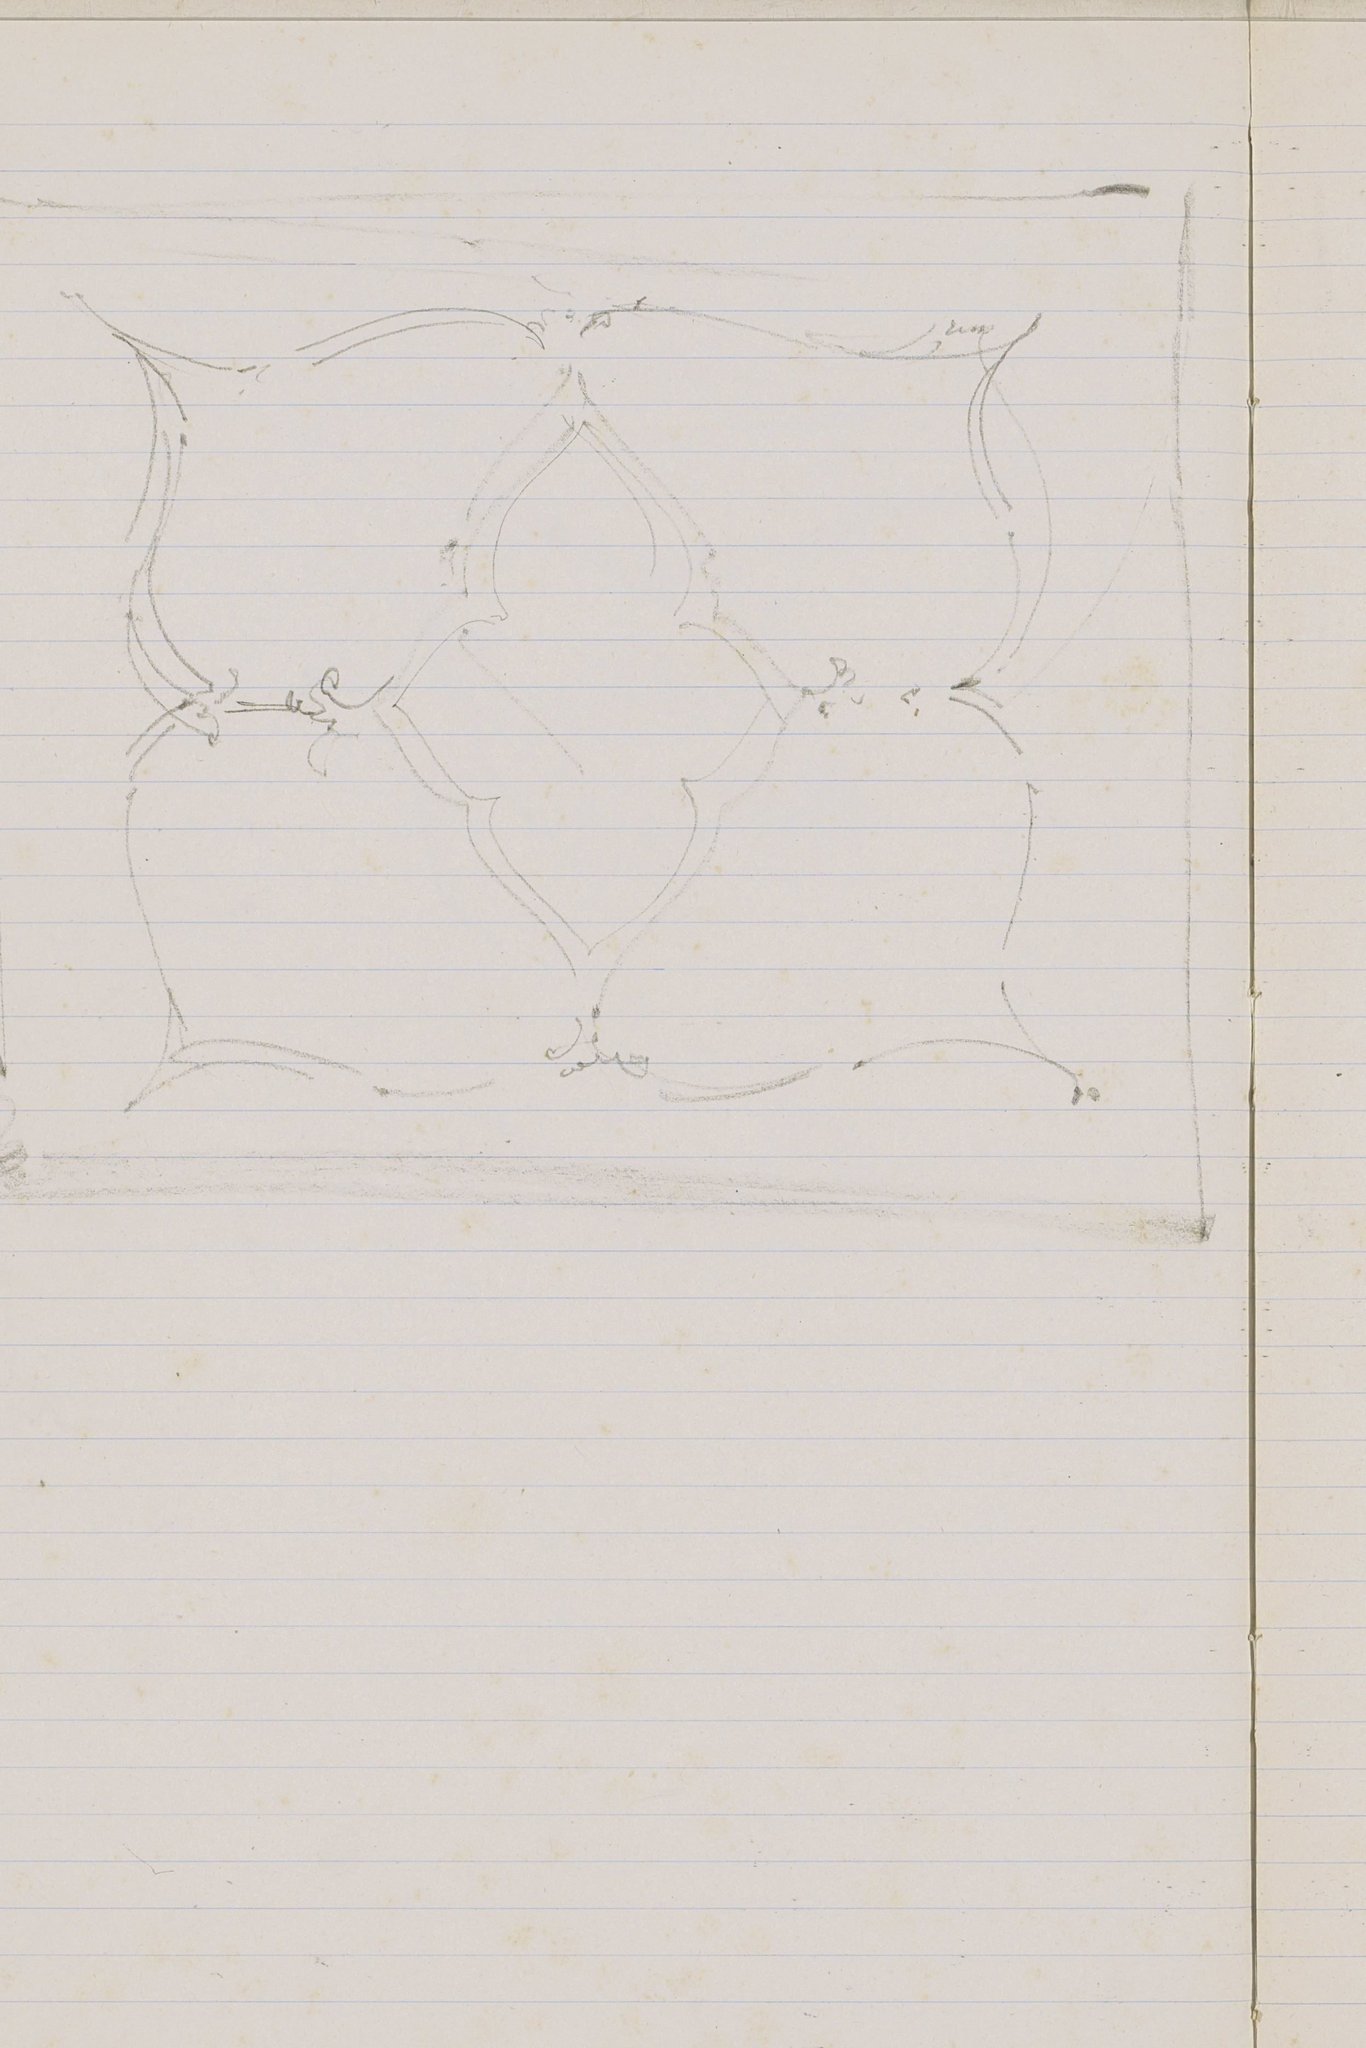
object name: sketchbook leaf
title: Gestileerde bloem in een vierkant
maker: gerrit willem dijsselhof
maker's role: designer, draughtsman, print maker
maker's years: 1866-1924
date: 1901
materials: chalk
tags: flowers ~ ornament - aa - stylized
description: Blad 76 verso uit een schetsboek met 79 bladen.